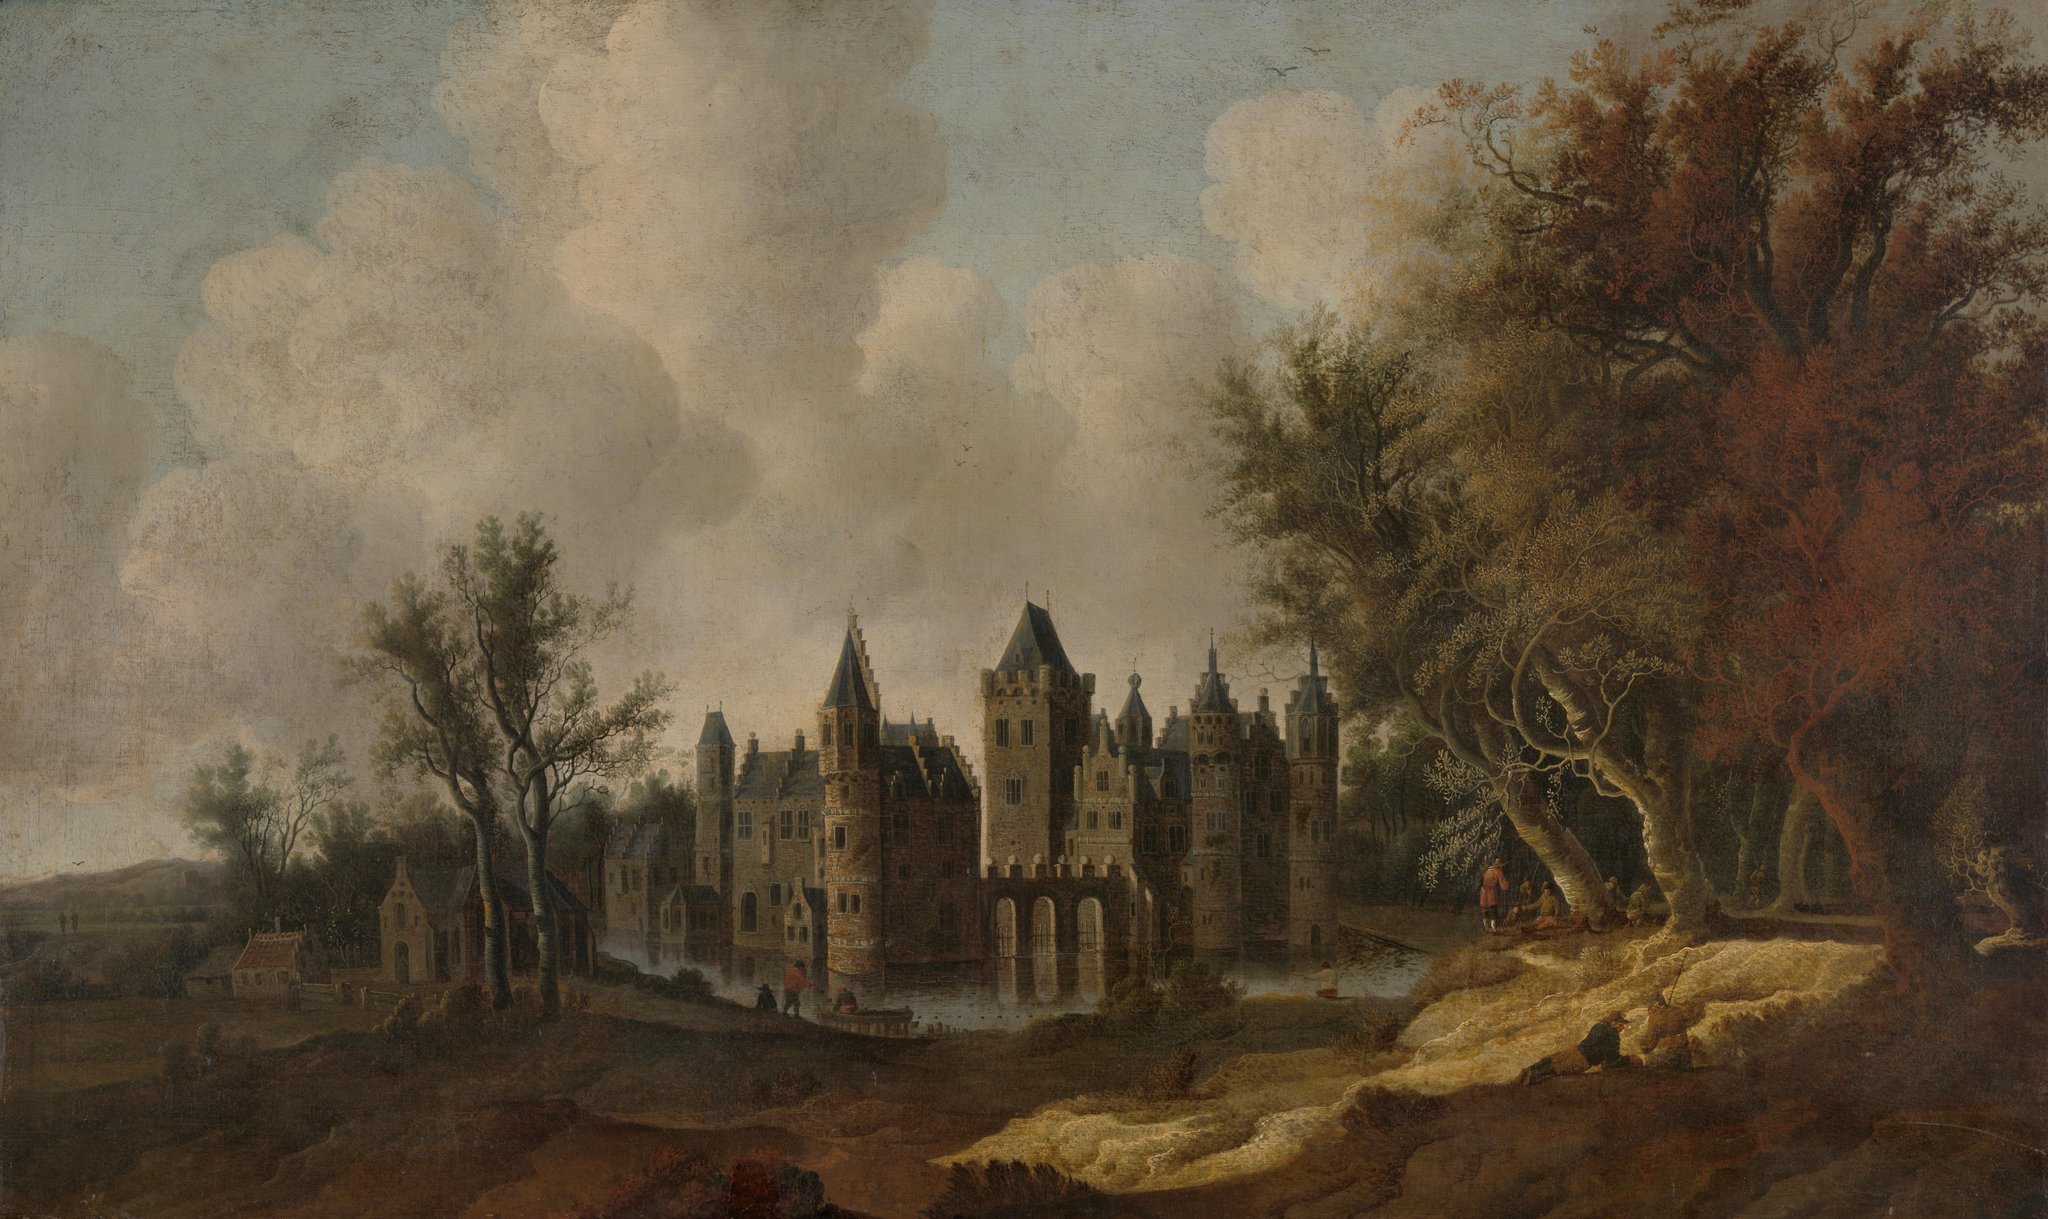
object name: painting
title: Egmond Castle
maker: g.w. berckhout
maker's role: draughtsman, painter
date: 1653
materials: canvas, oil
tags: castle, egmond aan den hoef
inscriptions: signature and date: ‘G.W. berckhout 1653’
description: Landschap met het slot Egmond aan den Hoef, in de oorspronkelijke toestand.